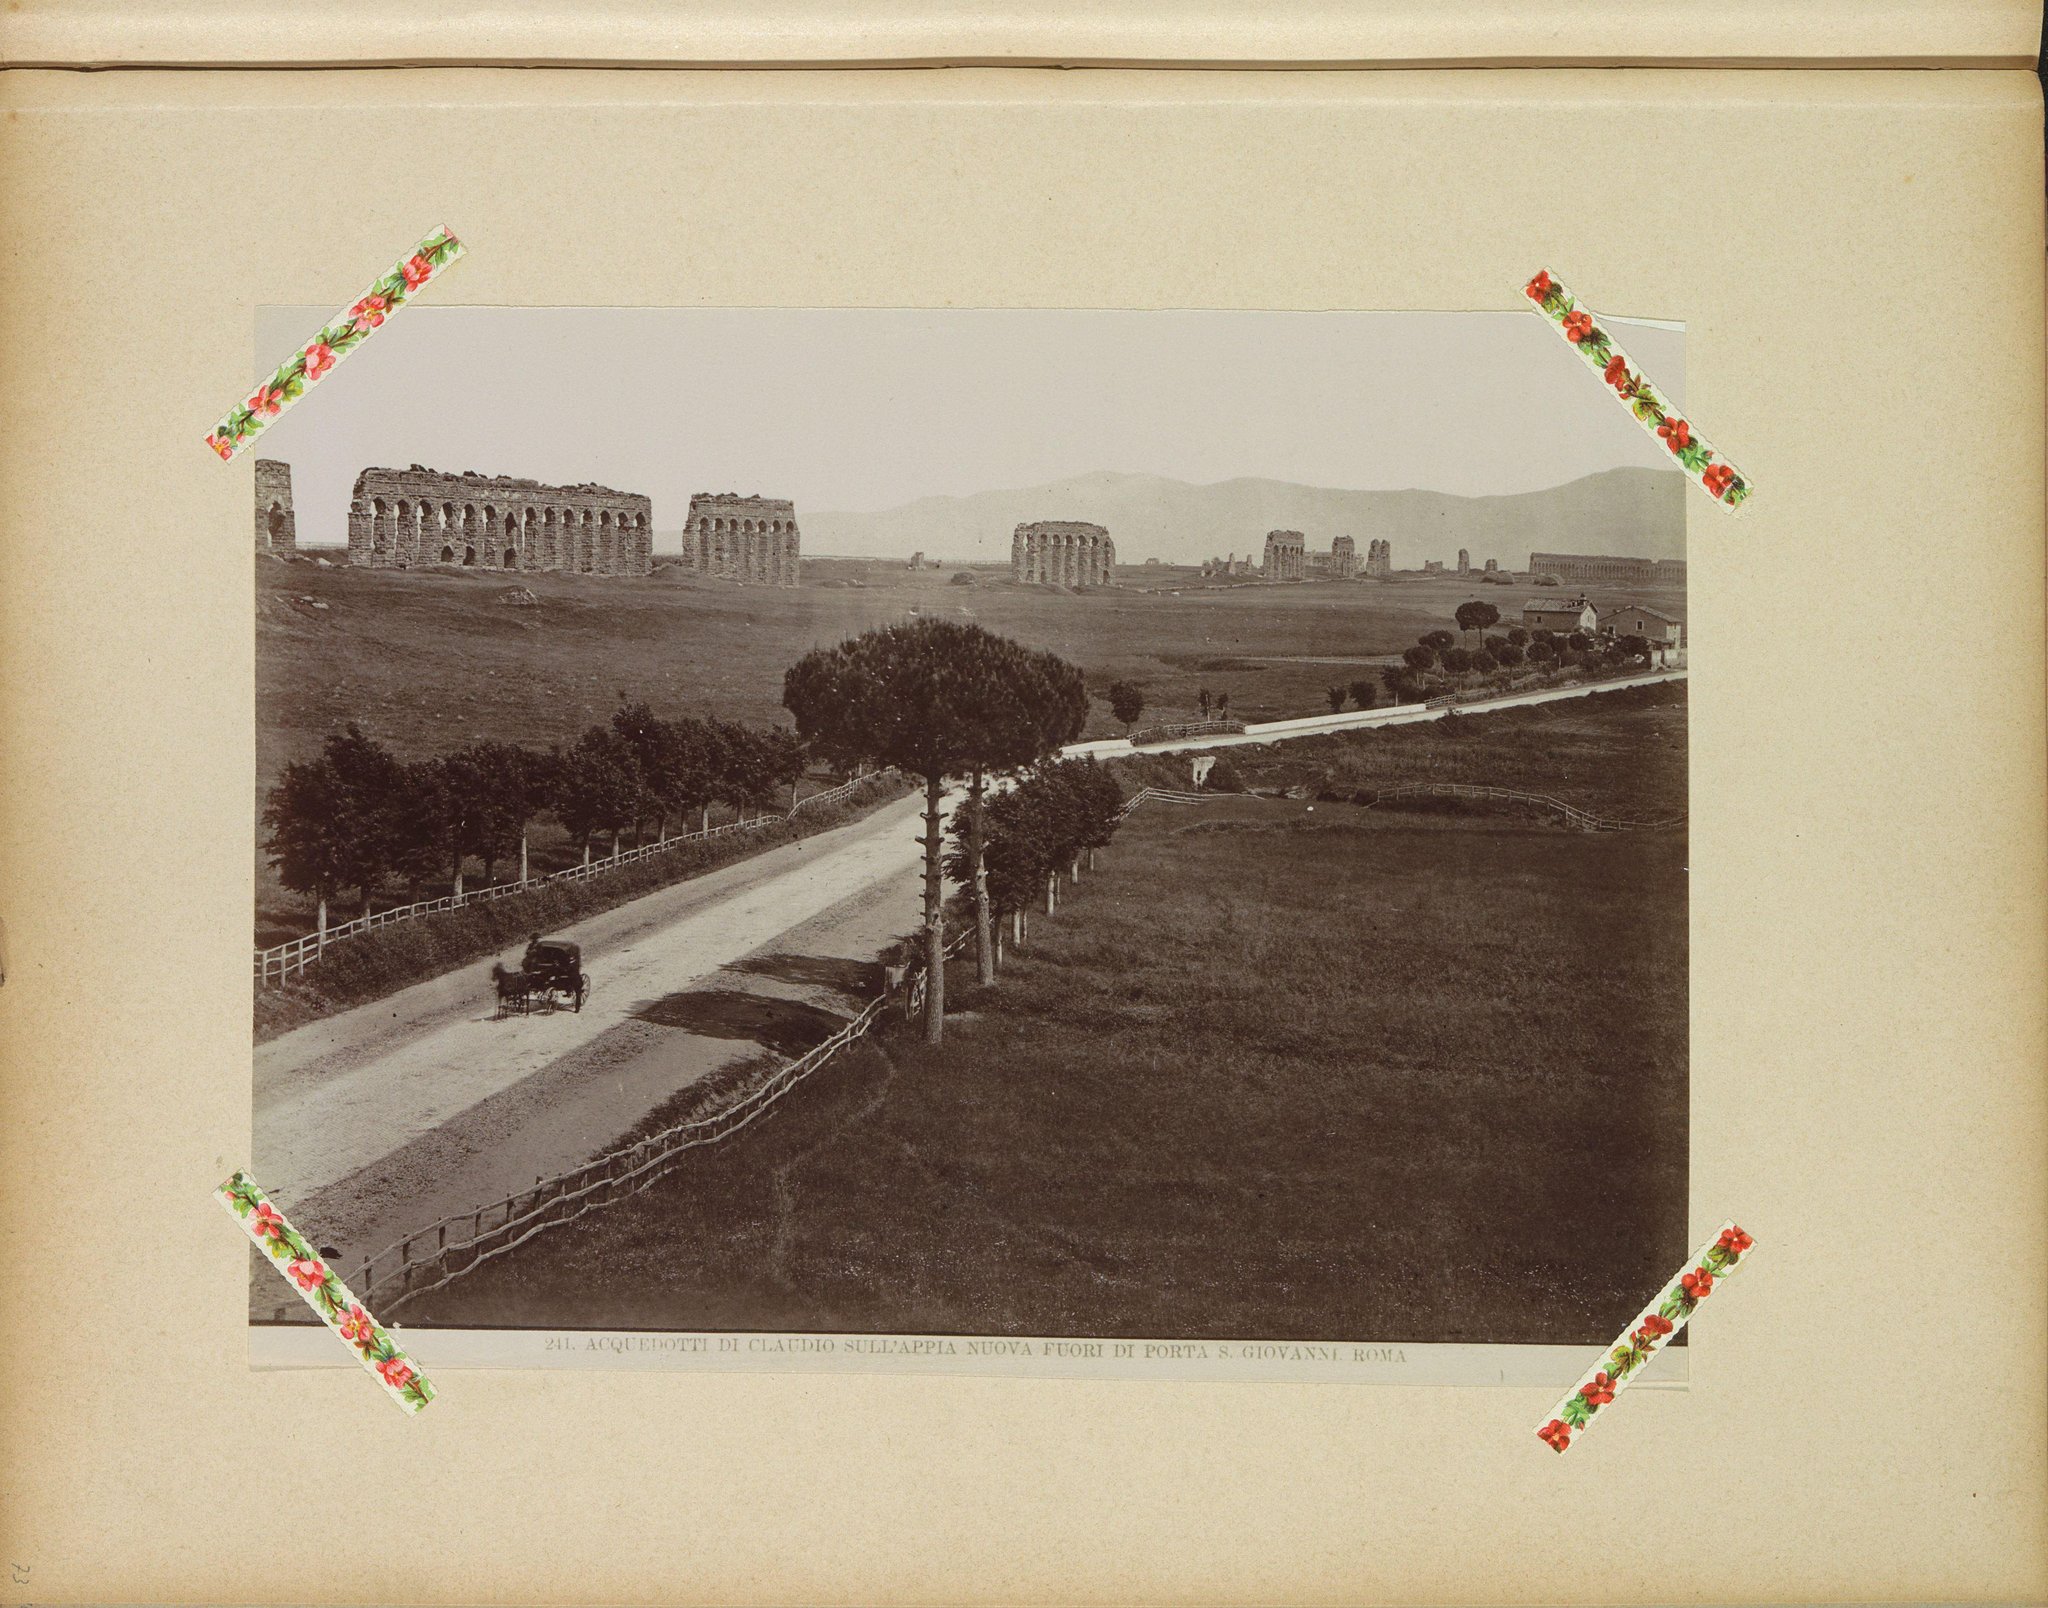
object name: photograph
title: Acquedotti di Claudio sull'Appia Nuova fuoro di Porta S. Giovanni. Roma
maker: Anonymous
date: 1860-1900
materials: photographic support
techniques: albumen print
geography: rome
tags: landscape with bridge, viaduct or aqueduct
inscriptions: number: ‘241’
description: Onderdeel van Fotoalbum met opnames van bezienswaardigheden in Italiaanse steden en van kunstwerken.